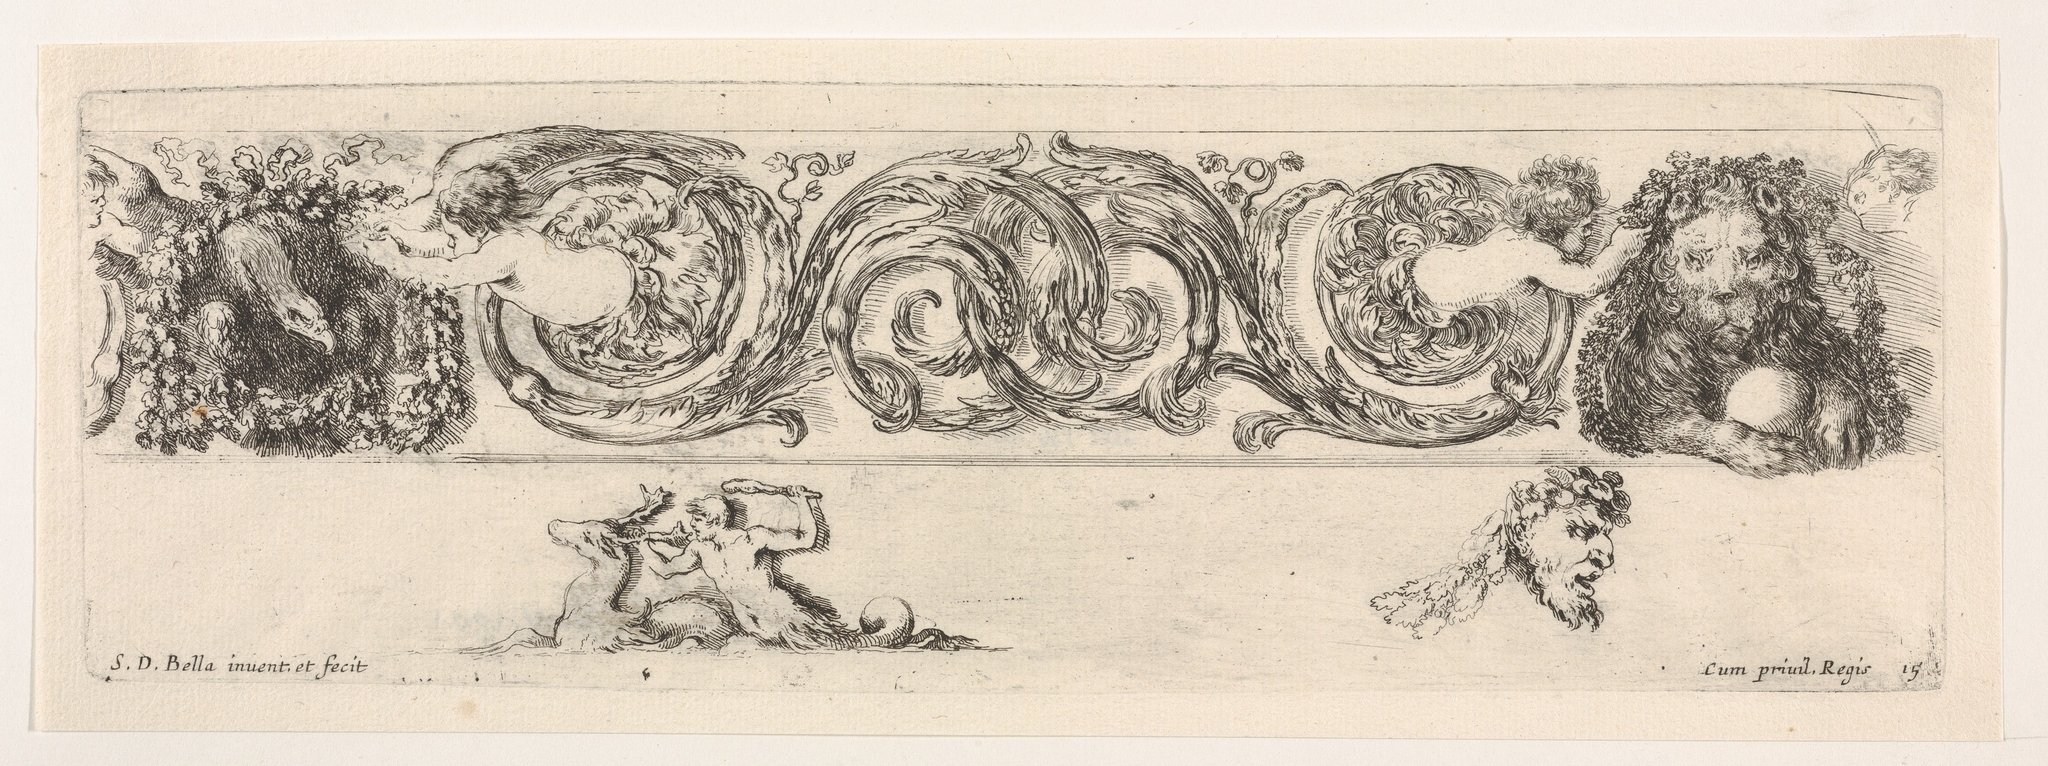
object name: print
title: Design for a Frieze with Acanthus Scrolls and Two Small Figural Motifs Below, plate 15 from "Decorative friezes and foliage" (Ornamenti di fregi e fogliami)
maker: stefano della bella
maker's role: artist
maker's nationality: italian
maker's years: 1610-1664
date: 1645-1650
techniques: etching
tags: birds,ornament,putti,deer,lions